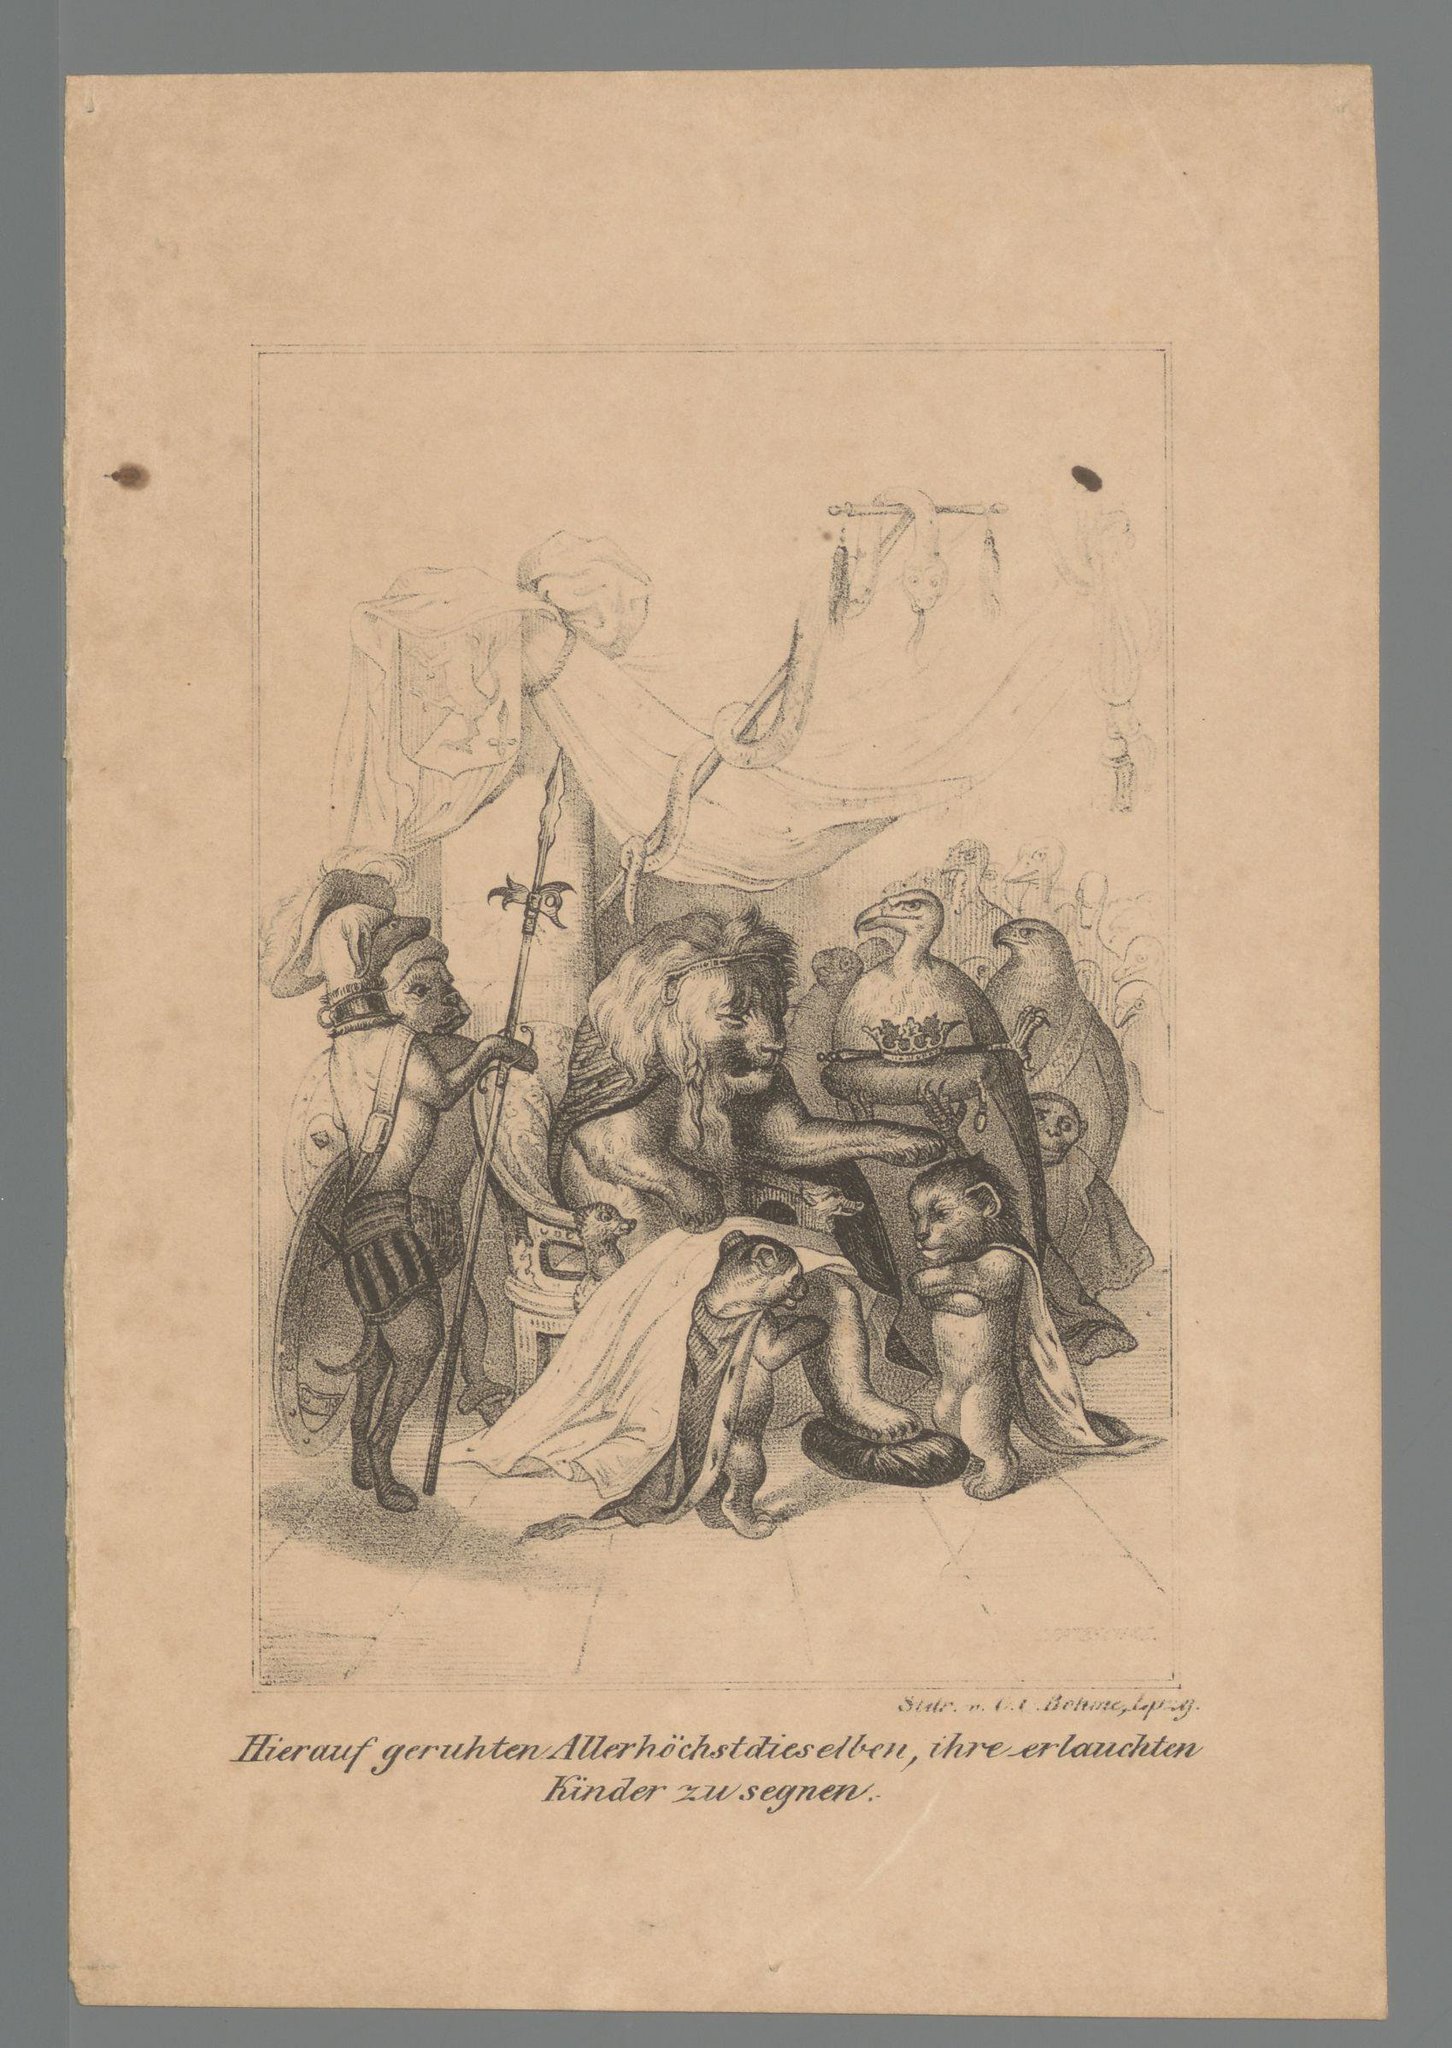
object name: book illustration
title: Hierauf geruhten Allerhöchstdieselben, ihre erlauchten Kïnder zu segnen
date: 1841-1842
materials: paper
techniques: lithograph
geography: leipzig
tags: animals acting as human beings, throne-room, beasts of prey, predatory animals: lion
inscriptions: collector's mark: Lugt 2228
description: Prent uit: Gerard, Jean-Ignace-Isidore. Das neunzehnte Jahrhundert des Thierreichs oder Scenen aus dem Familien- und Staatsleben der Thiere. Leipzig: Friedrich Volckmar, [1841-1842].